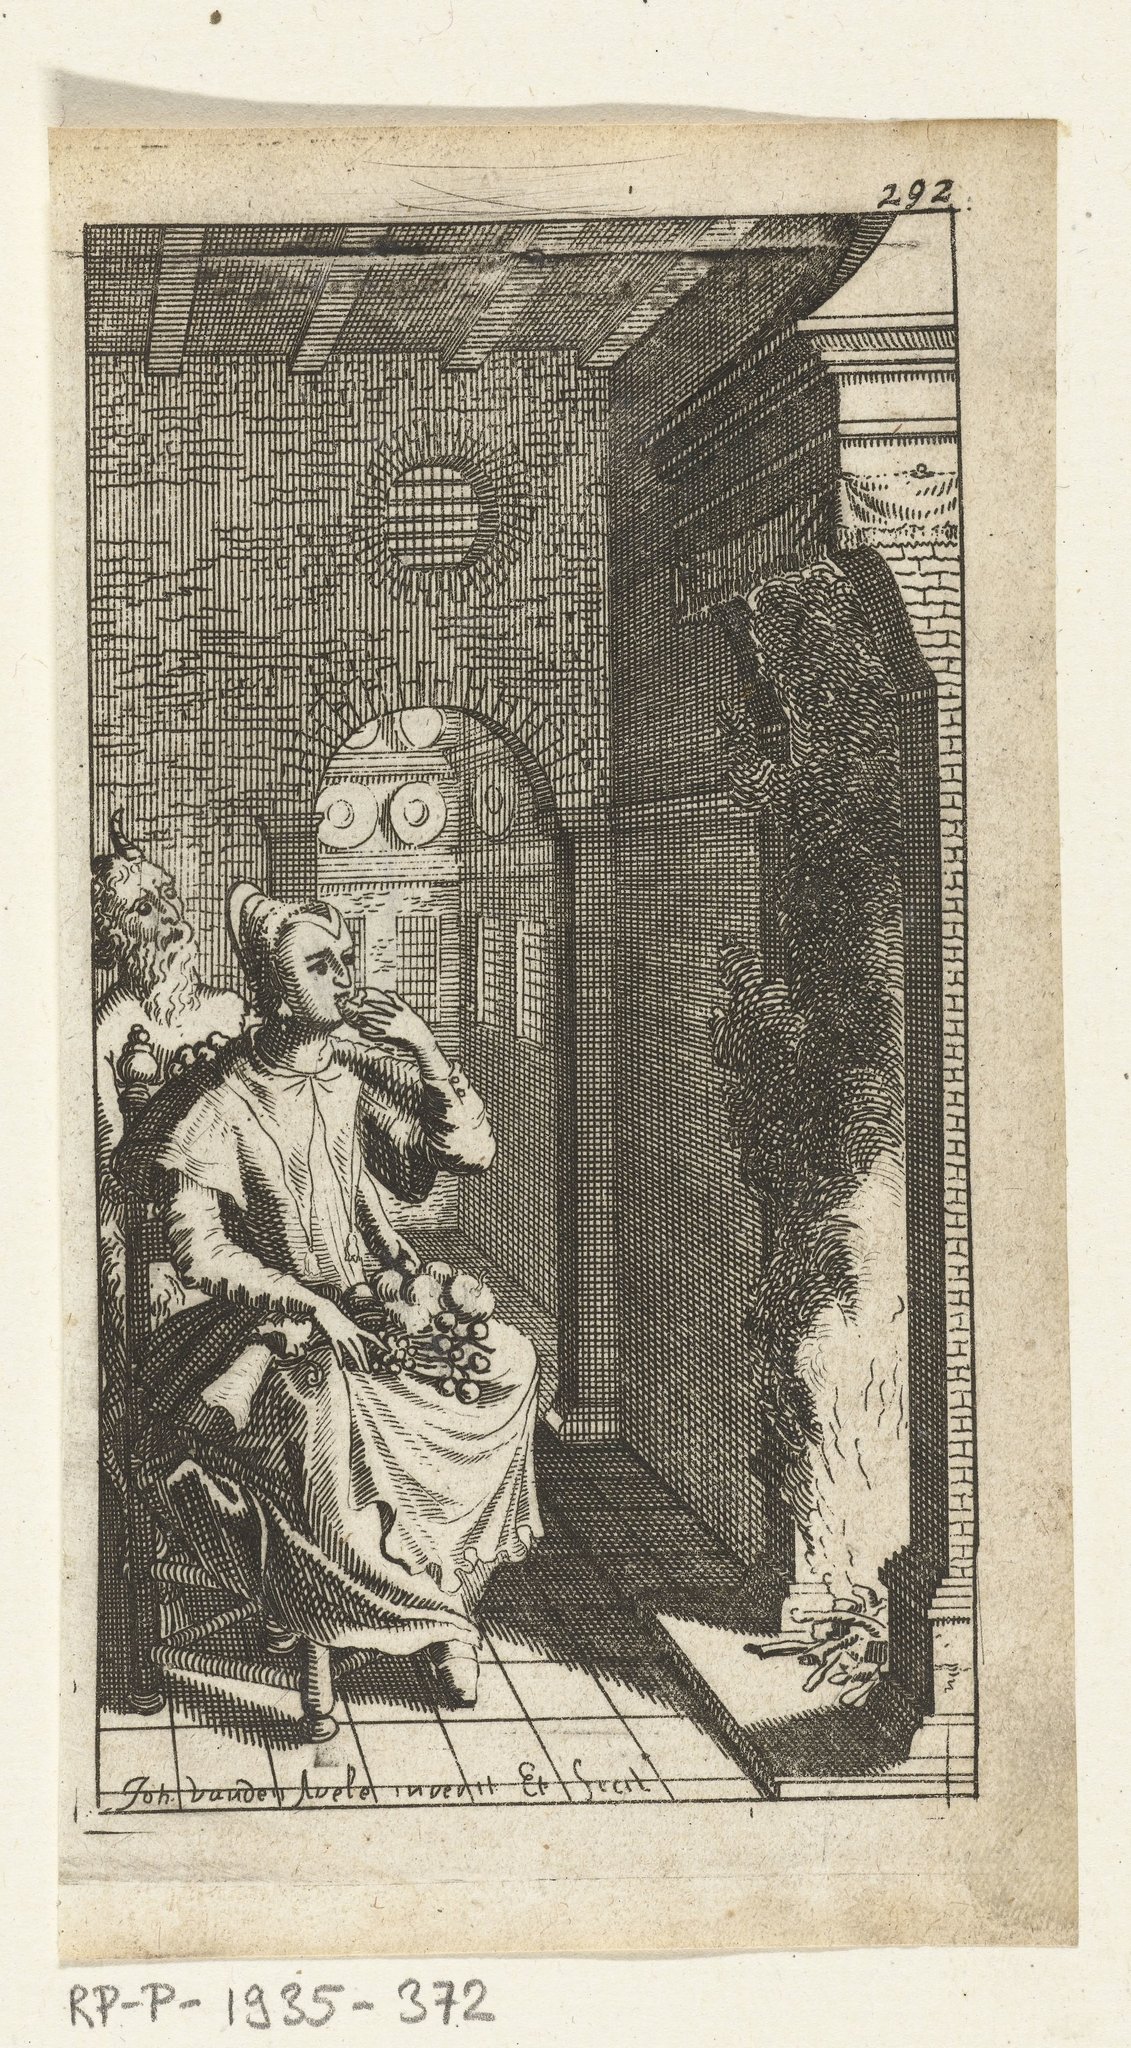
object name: print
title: De lekkere duivel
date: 1682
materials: paper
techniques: etching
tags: christian religion (+ devil(s)), maid ~ house personnel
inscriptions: collector's mark: Lugt 2760, collector's mark: Lugt 2228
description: Een dienstmeisje zit op een stoel bij een haardvuur. Ze eet fruit dat ze in haar schoot heeft liggen. Achter haar stoel staat een duivel.